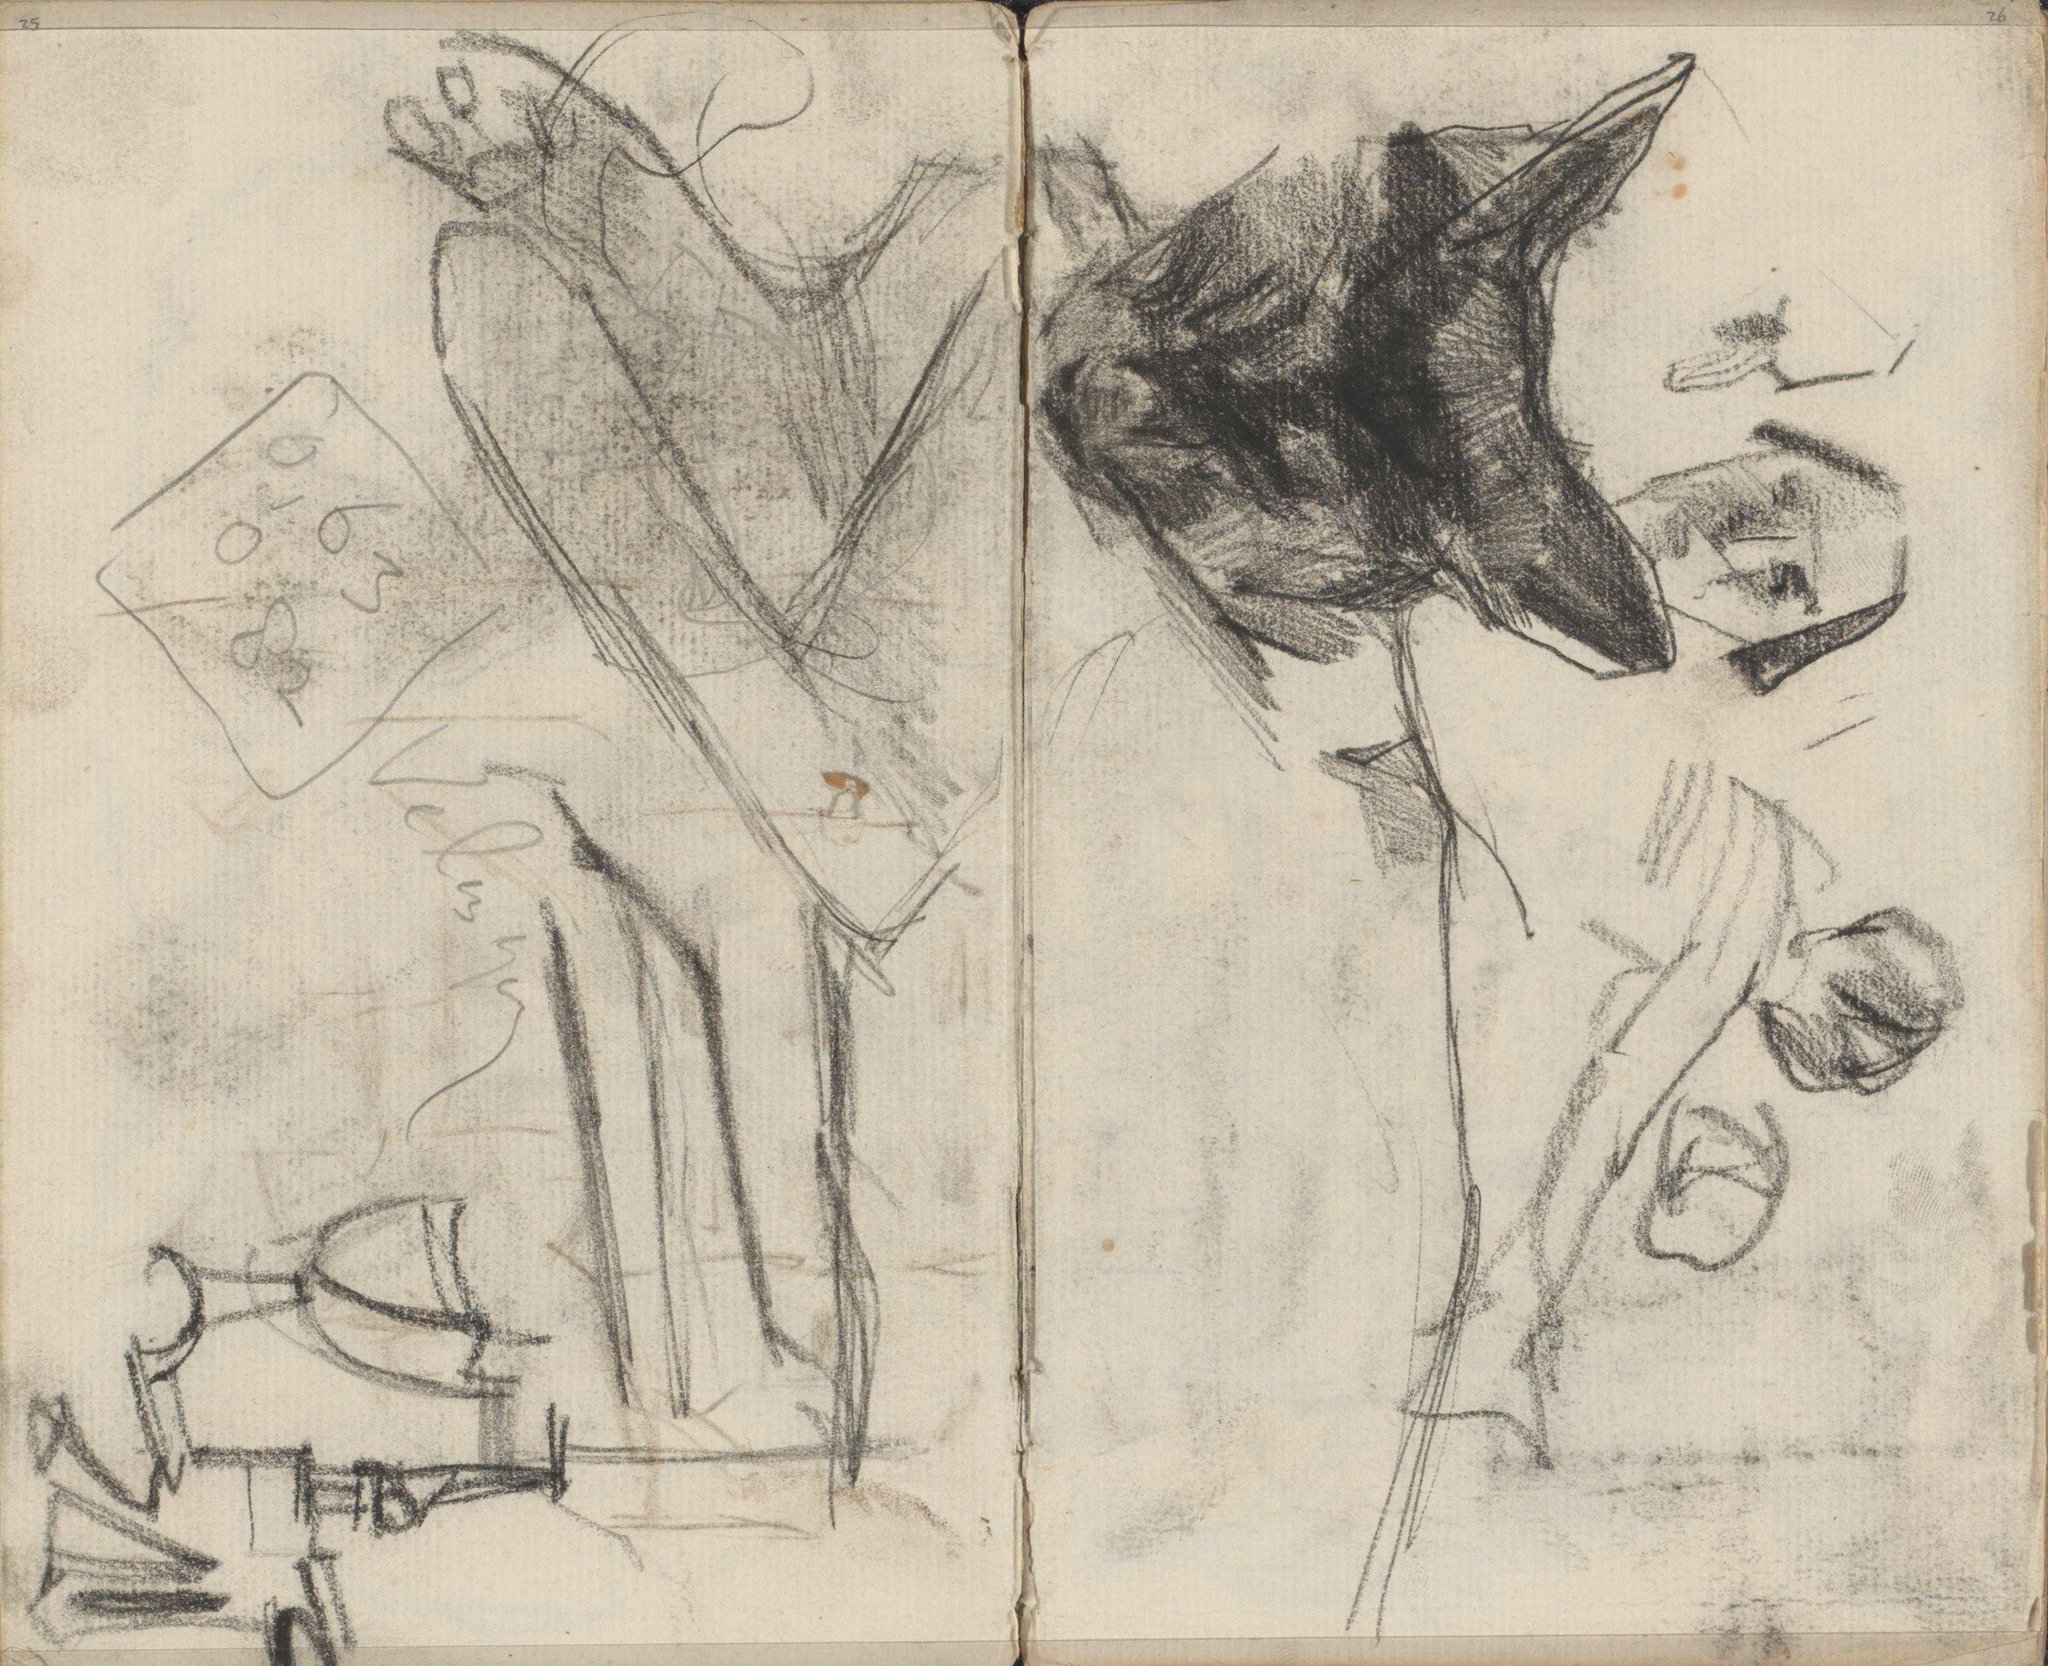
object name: sketchbook leaf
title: Studieblad met figuren, een liggende kat en voorwerpen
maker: george hendrik breitner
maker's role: draughtsman, painter, print maker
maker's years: 1857-1923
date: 1884-1886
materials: chalk, paper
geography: paris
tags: adult woman, cat, adult man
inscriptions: annotation: ‘[...]’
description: Pagina 25 en pagina 26 uit een schetsboek met 25 bladen.